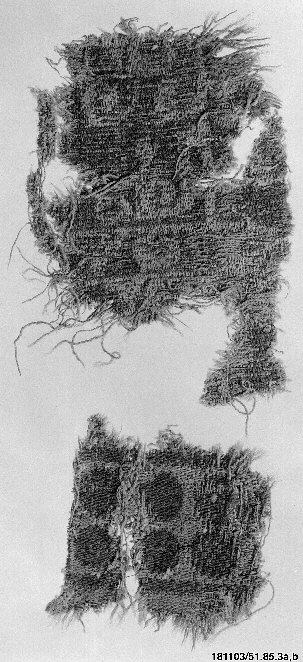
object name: carpet fragment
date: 701-900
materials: wool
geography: egypt